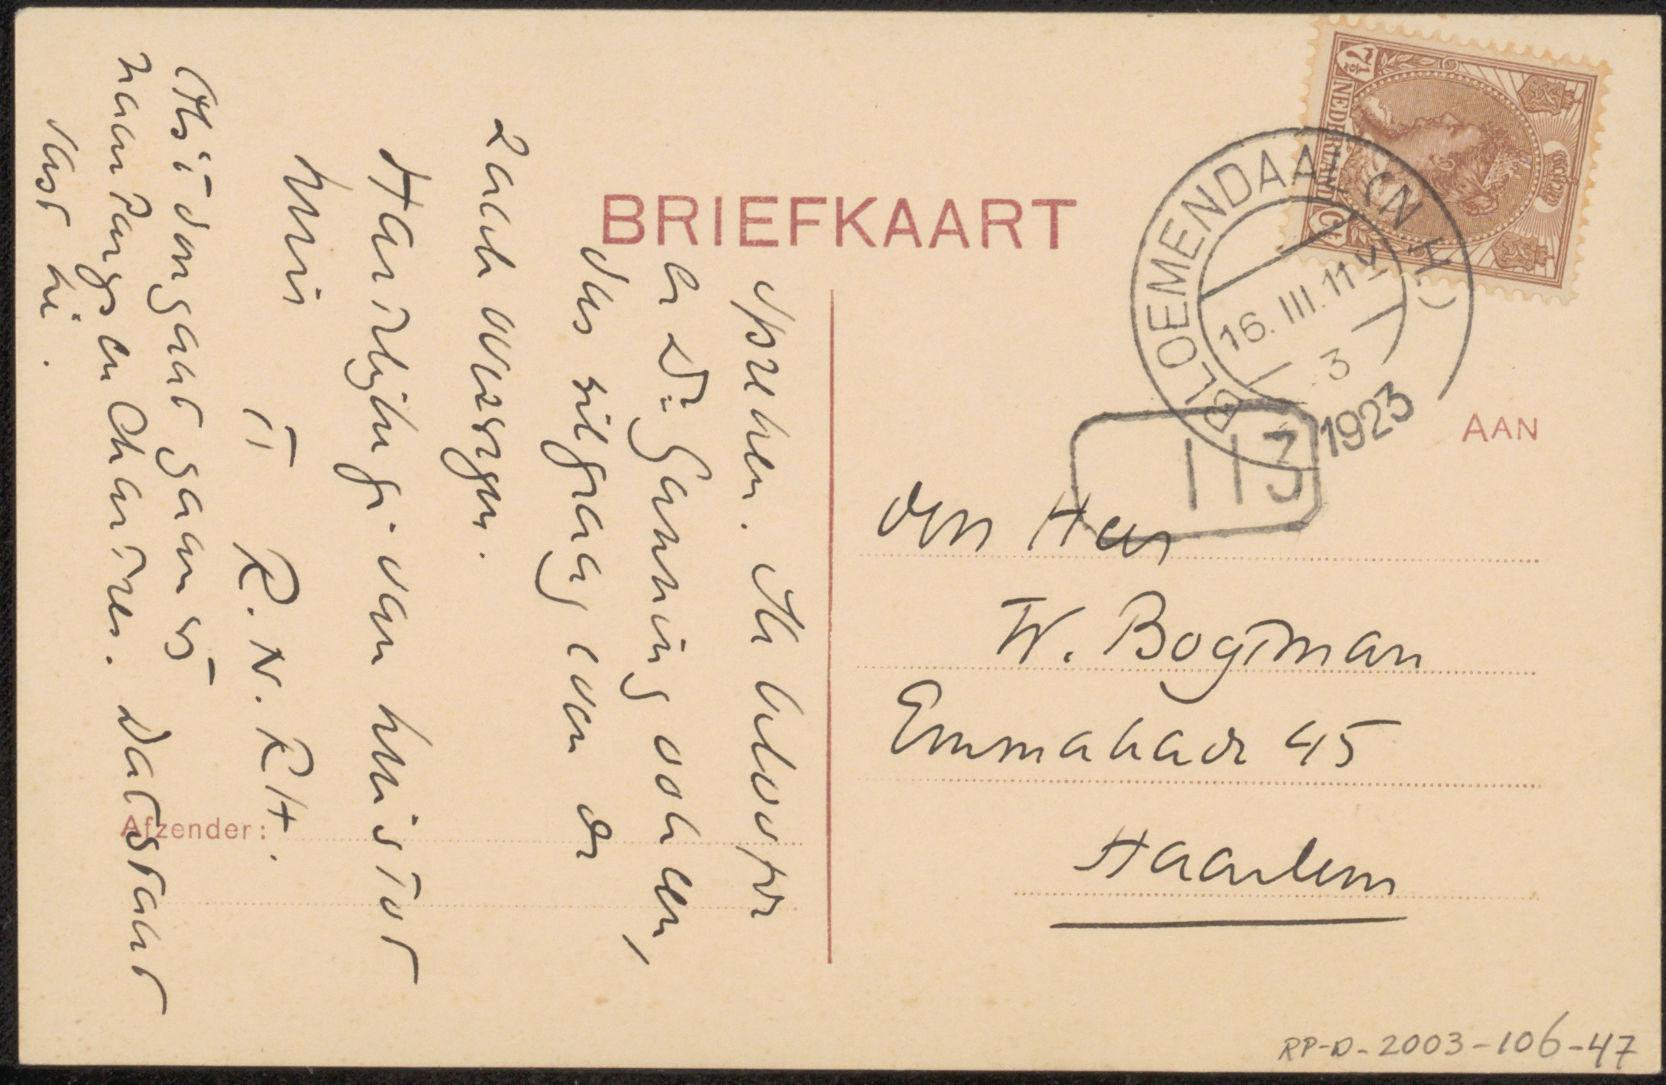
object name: postcard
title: Briefkaart aan Willem Bogtman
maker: richard nicolaüs roland holst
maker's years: 1868-1938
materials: cardboard, ink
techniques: pen, writing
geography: bloemendaal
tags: utrecht, amsterdam, christiaan pieter gunning, willem bogtman, drawing, paris